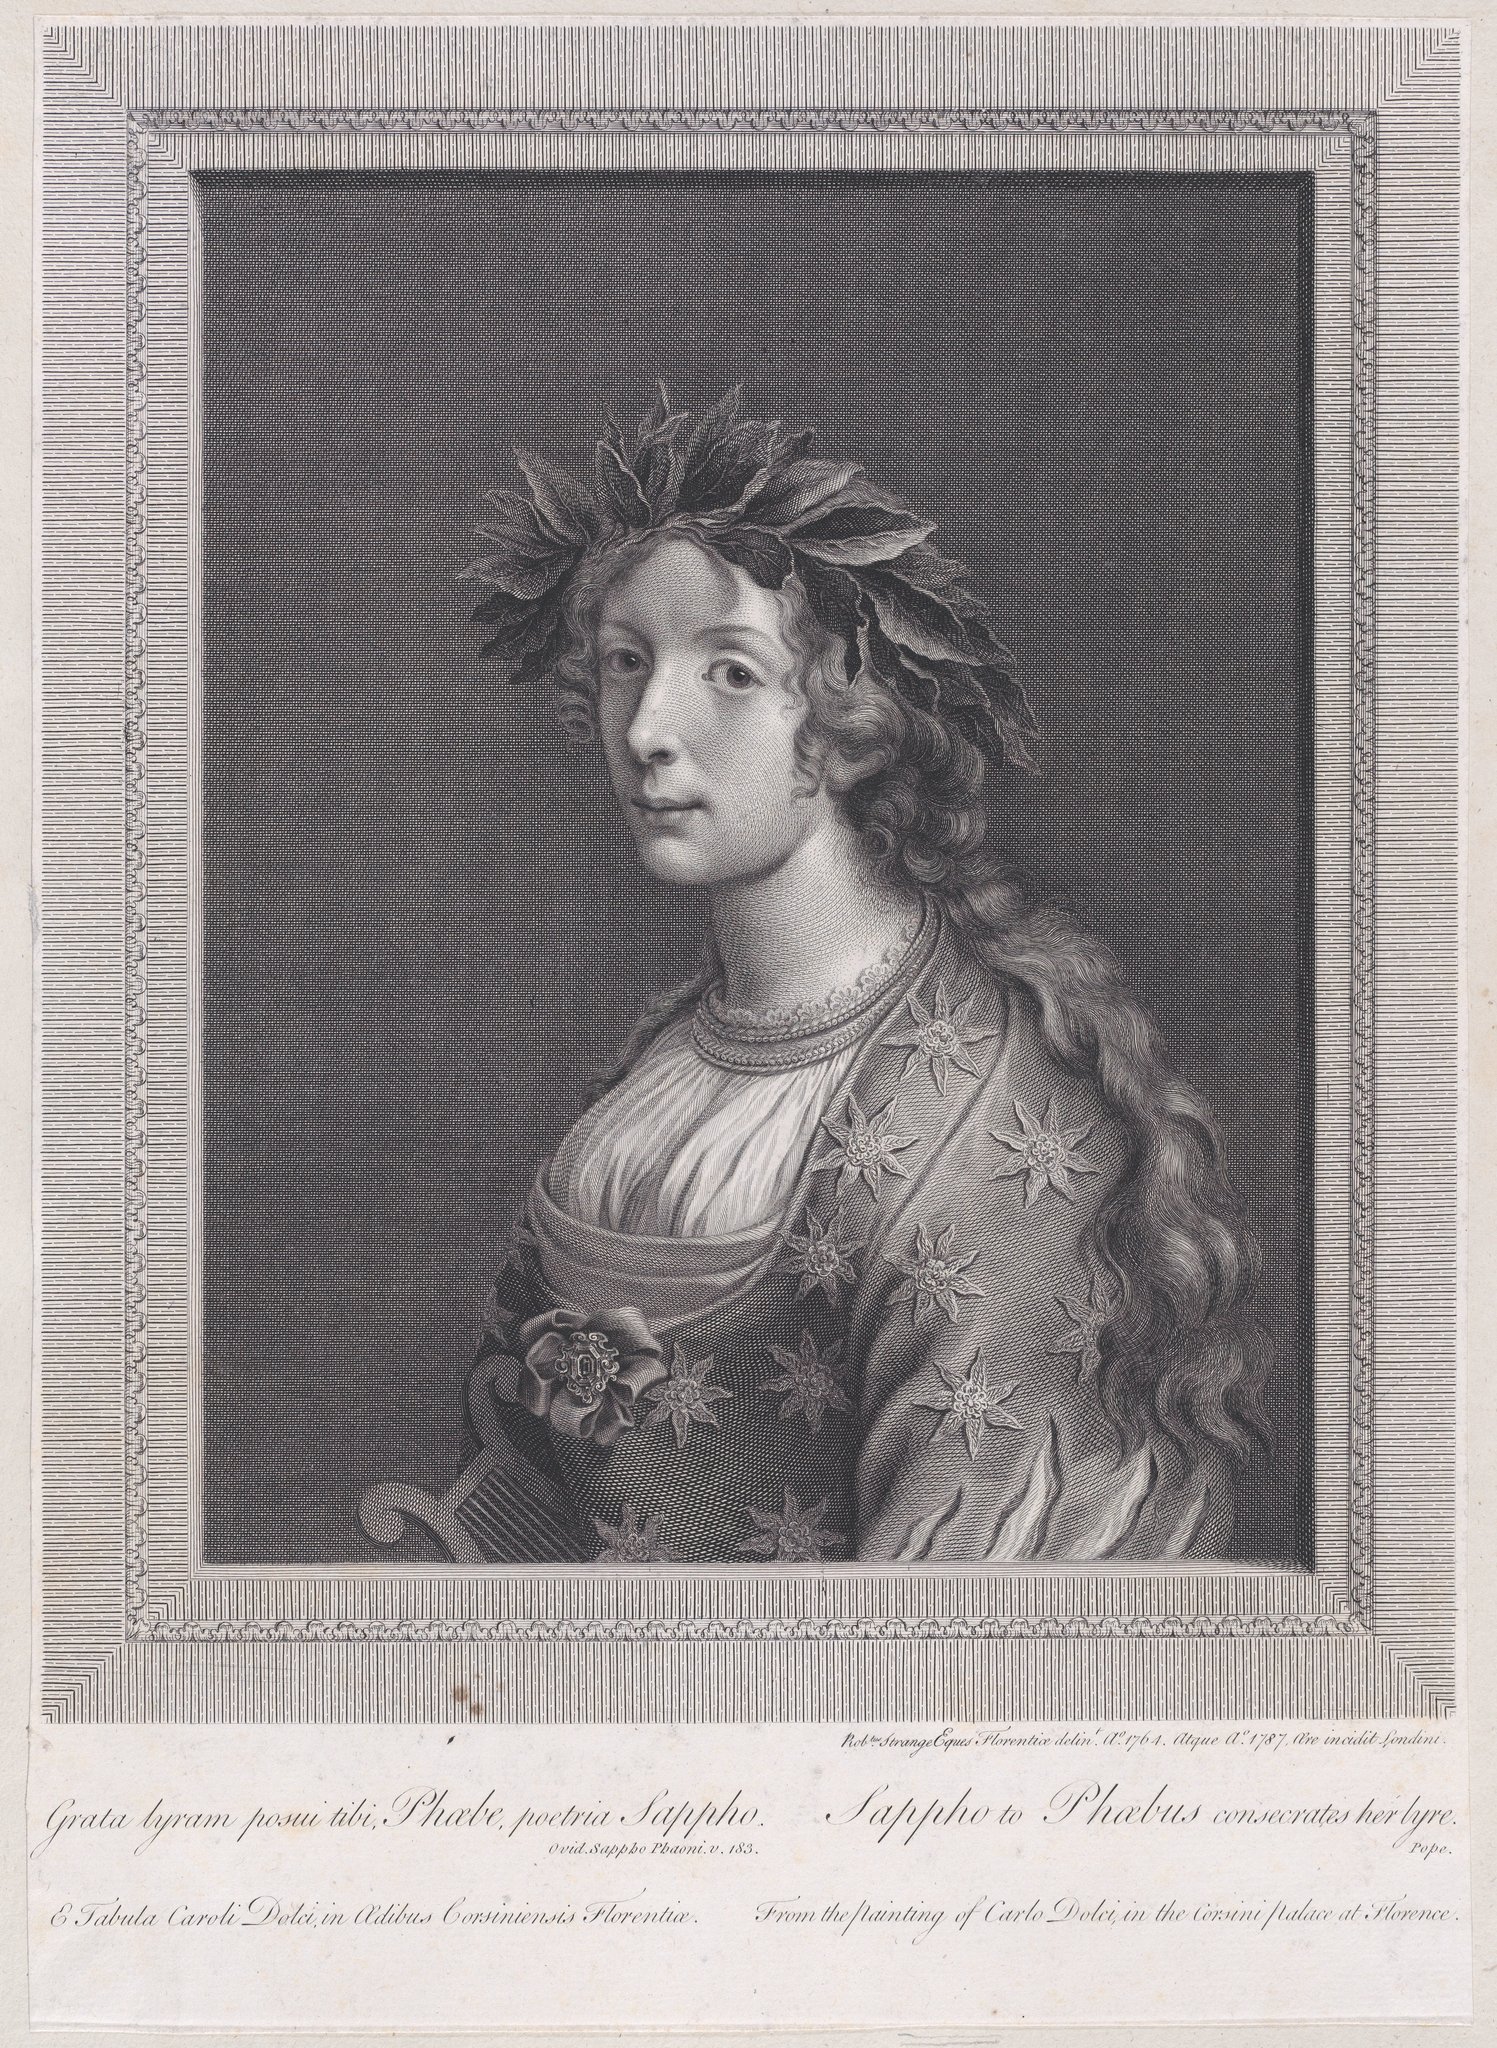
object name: print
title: Sappho to Phoebus consecrates her lyre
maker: robert strange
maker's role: artist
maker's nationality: british, scottish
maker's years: 1721-1792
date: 1787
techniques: engraving, etching